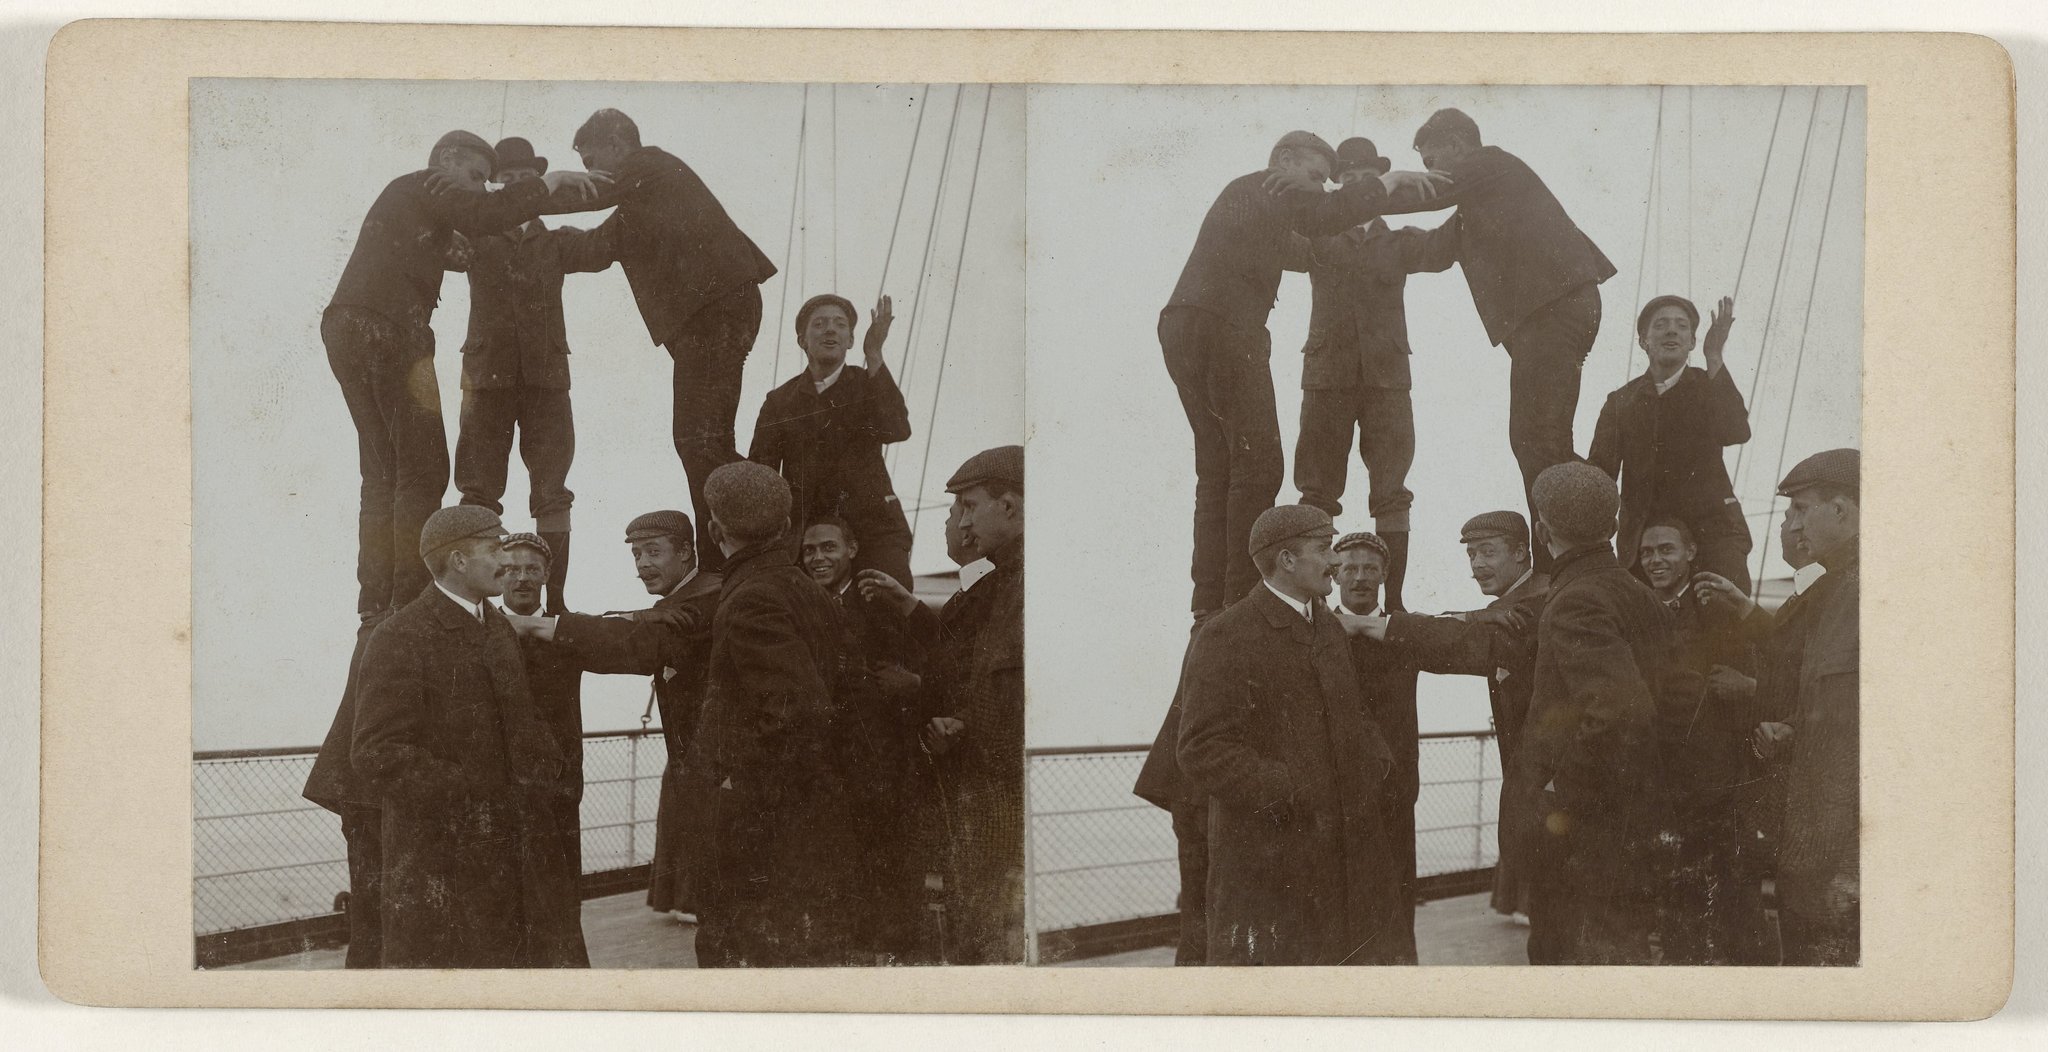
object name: stereograph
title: Menselijke piramide op het dek van een schip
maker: geldolph adriaan kessler (dolph)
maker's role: fotograaf, industrieel, voetballer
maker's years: 1884-1945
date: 1912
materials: paper, photographic support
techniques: collodion silver print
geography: vienna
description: Mogelijk een reis met het voetbalteam van Dolph Kessler naar Wenen